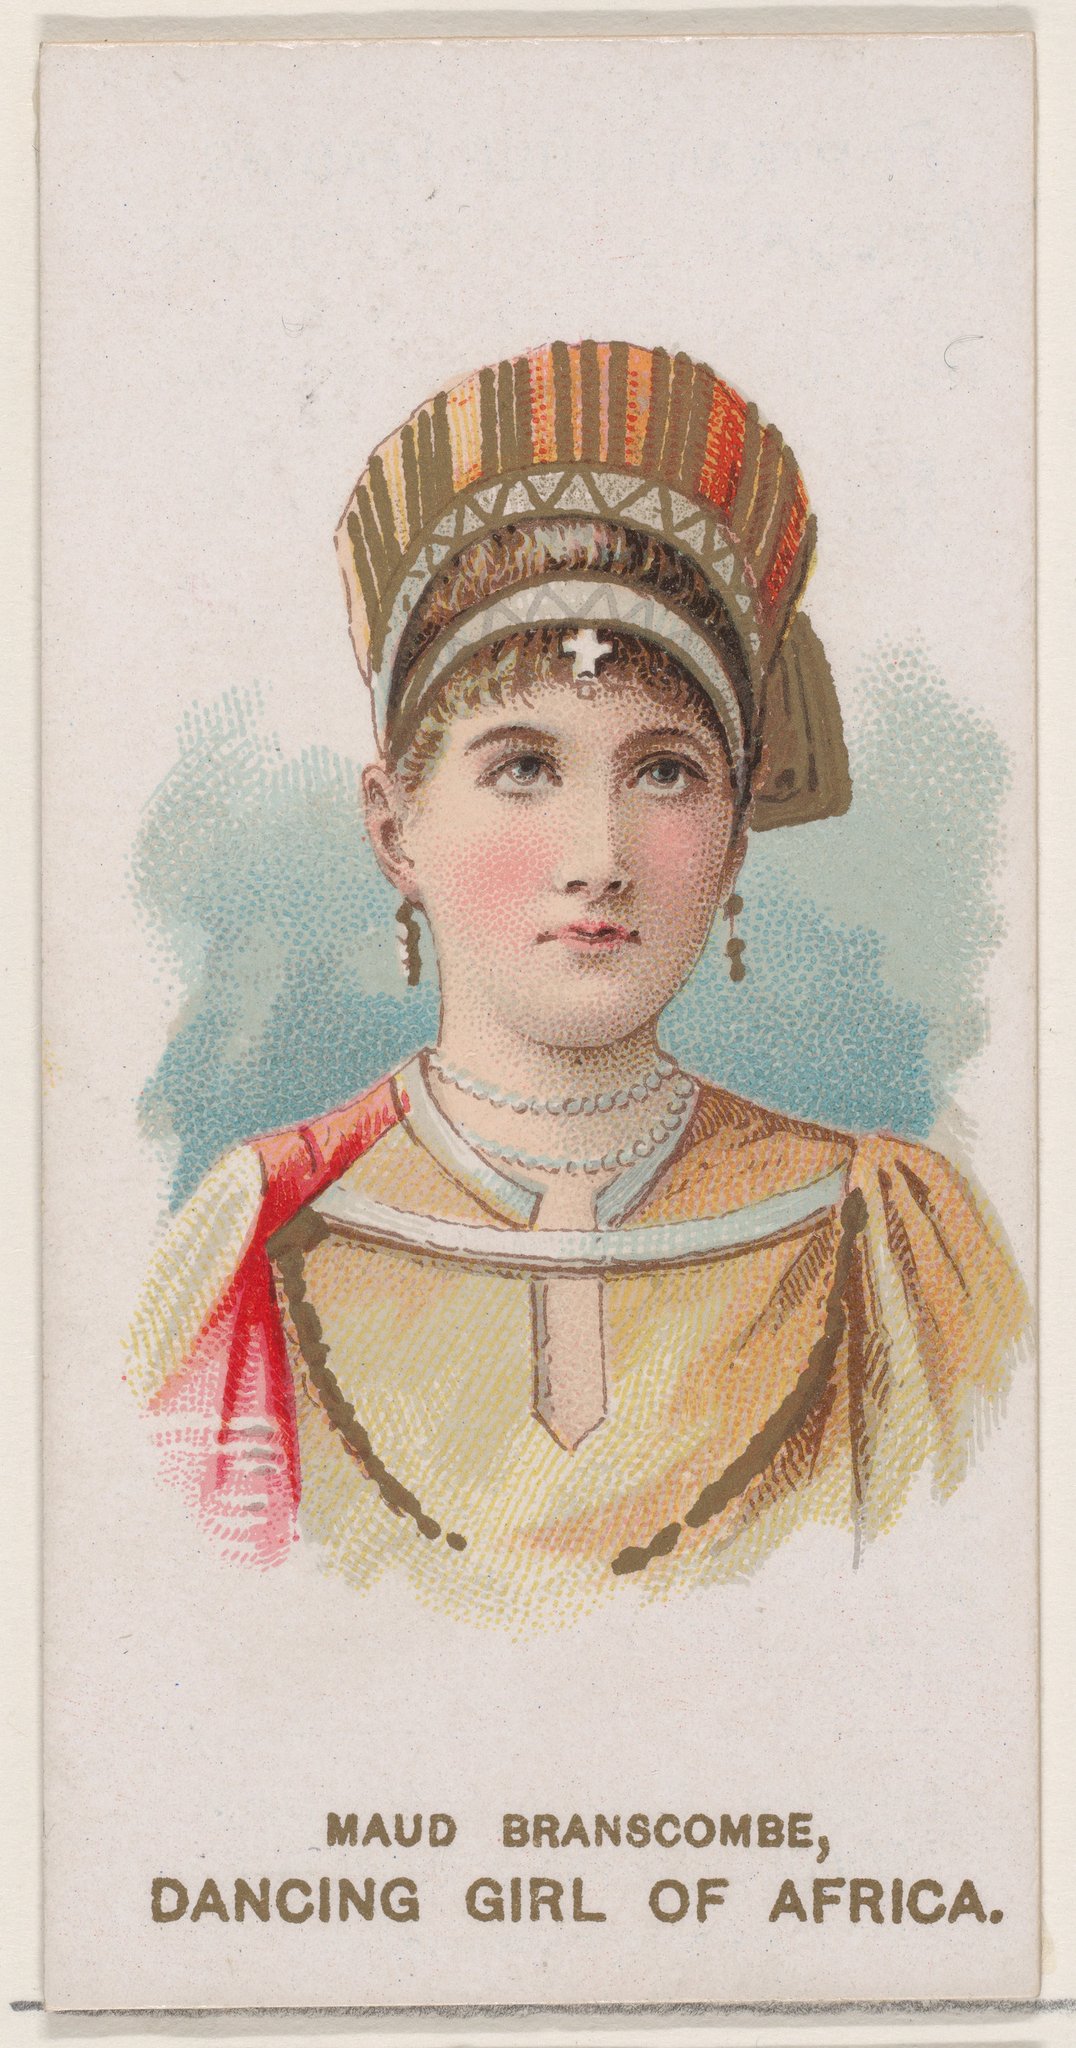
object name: print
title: Maud Branscombe Dressed as Dancing Girl of Africa, from the set Actors and Actresses, Second Series (N71) for Duke brand cigarettes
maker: w. duke, sons & co.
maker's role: publisher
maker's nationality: american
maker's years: 1870-1920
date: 1888-1890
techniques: color lithograph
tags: women,actresses